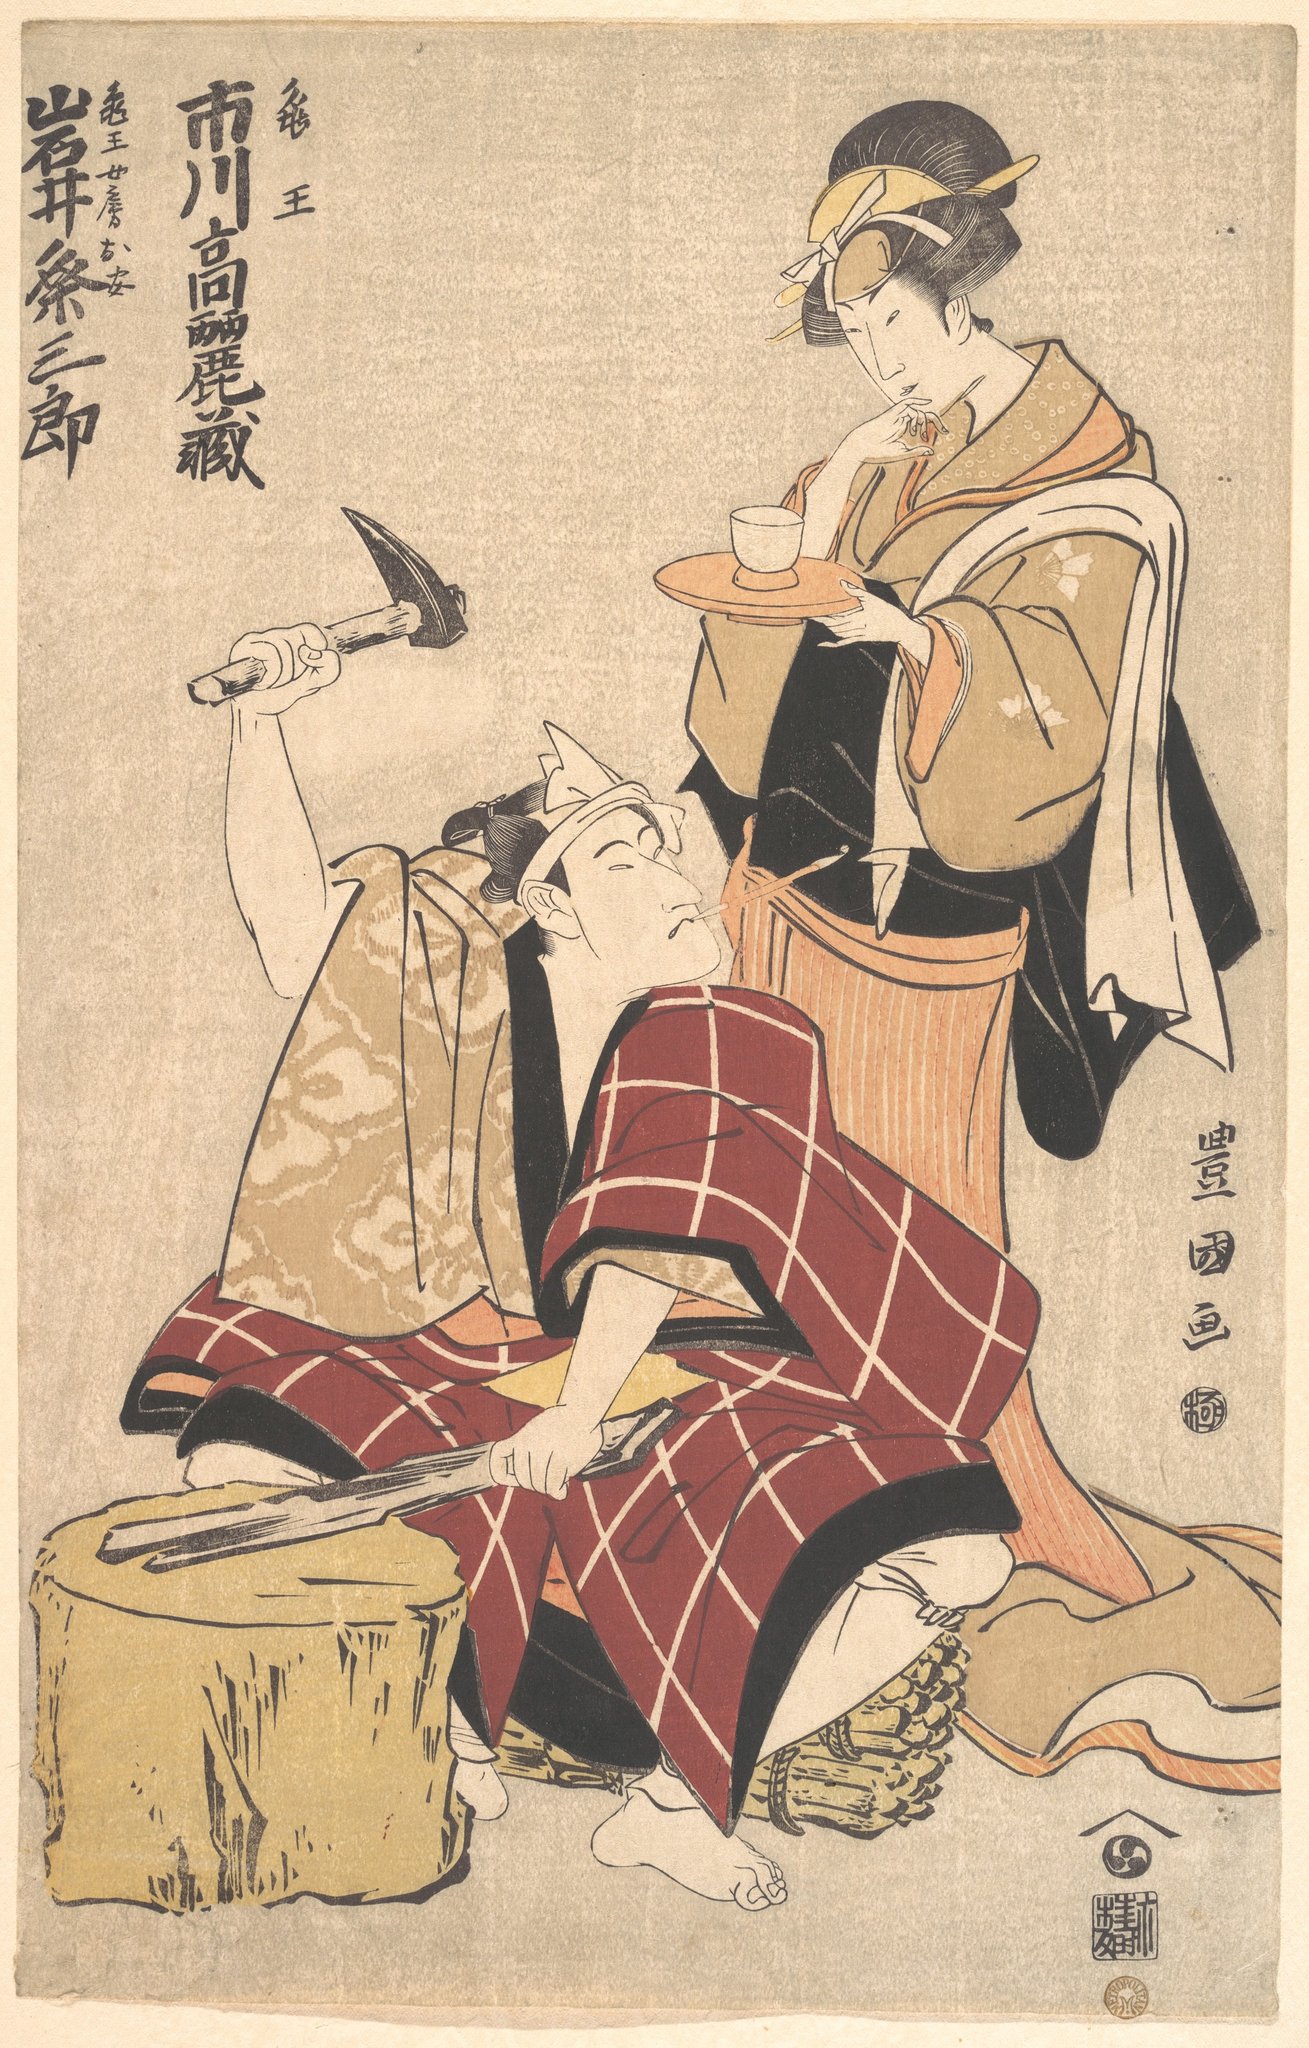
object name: print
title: Ichikawa Komazō III in the Role of Kameō with Iwai Kumesaburō in the Role of Kameō's Wife, Oyasu, from the Play Shunkan futatsu omokage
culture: japanese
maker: utagawa toyokuni i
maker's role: artist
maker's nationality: japanese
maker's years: 1769-1825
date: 1798-1799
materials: ink, paper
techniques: woodblock print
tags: men,women,actors